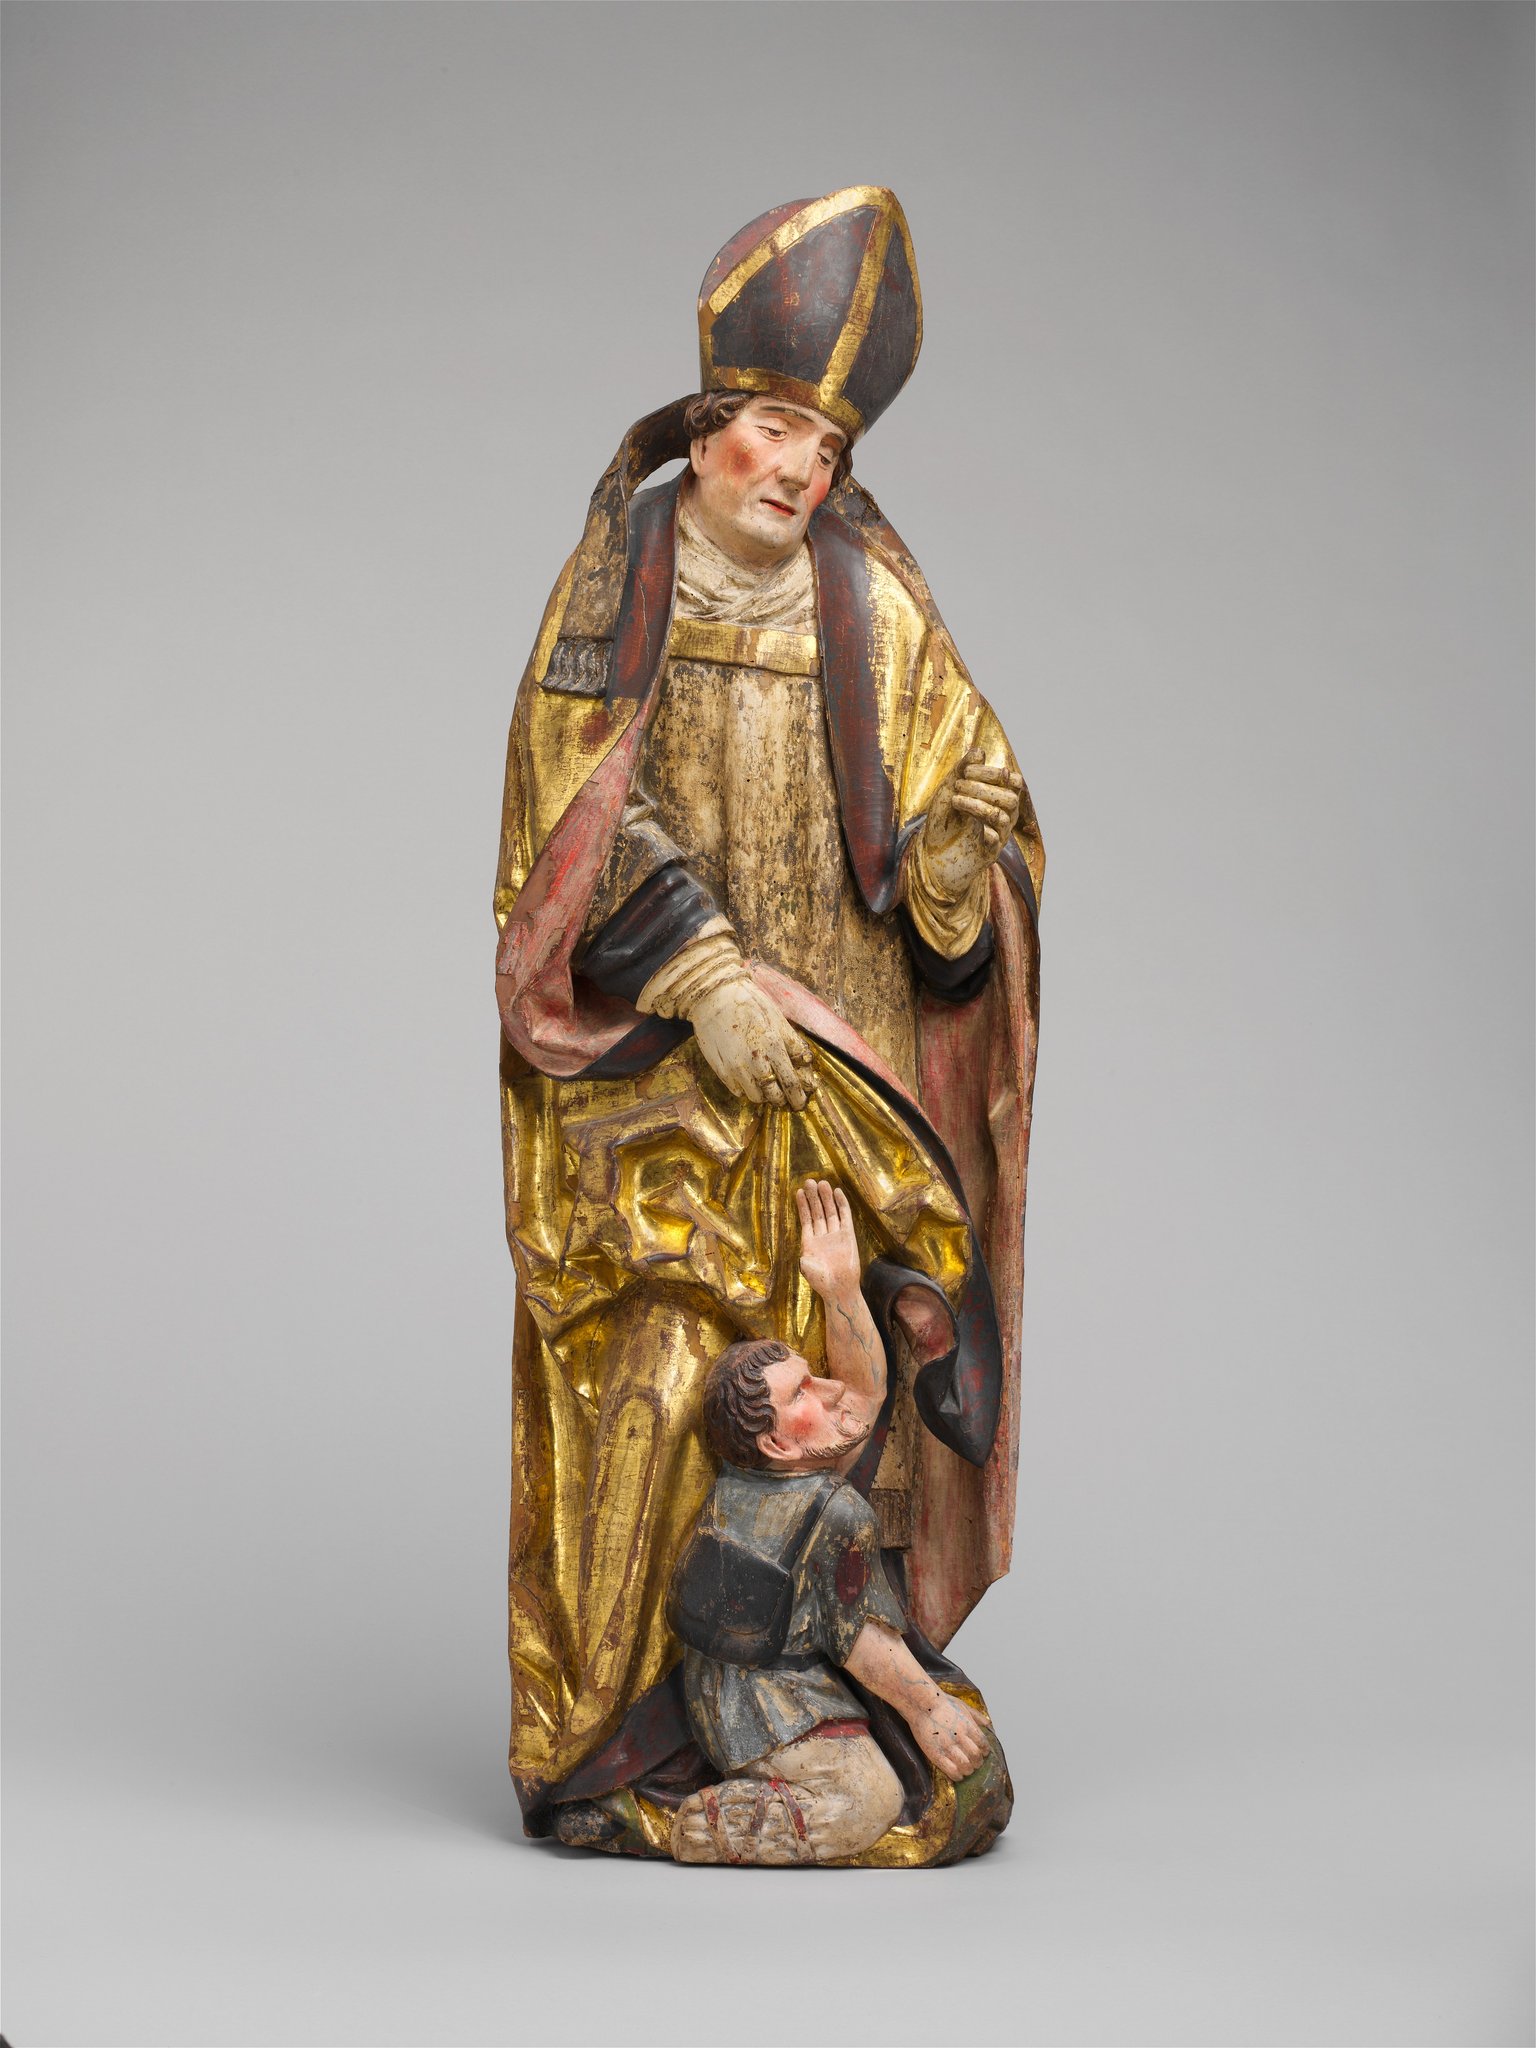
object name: statue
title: Saint Martin of Tours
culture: german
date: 1467-1533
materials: wood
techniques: gilding, polychromy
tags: men